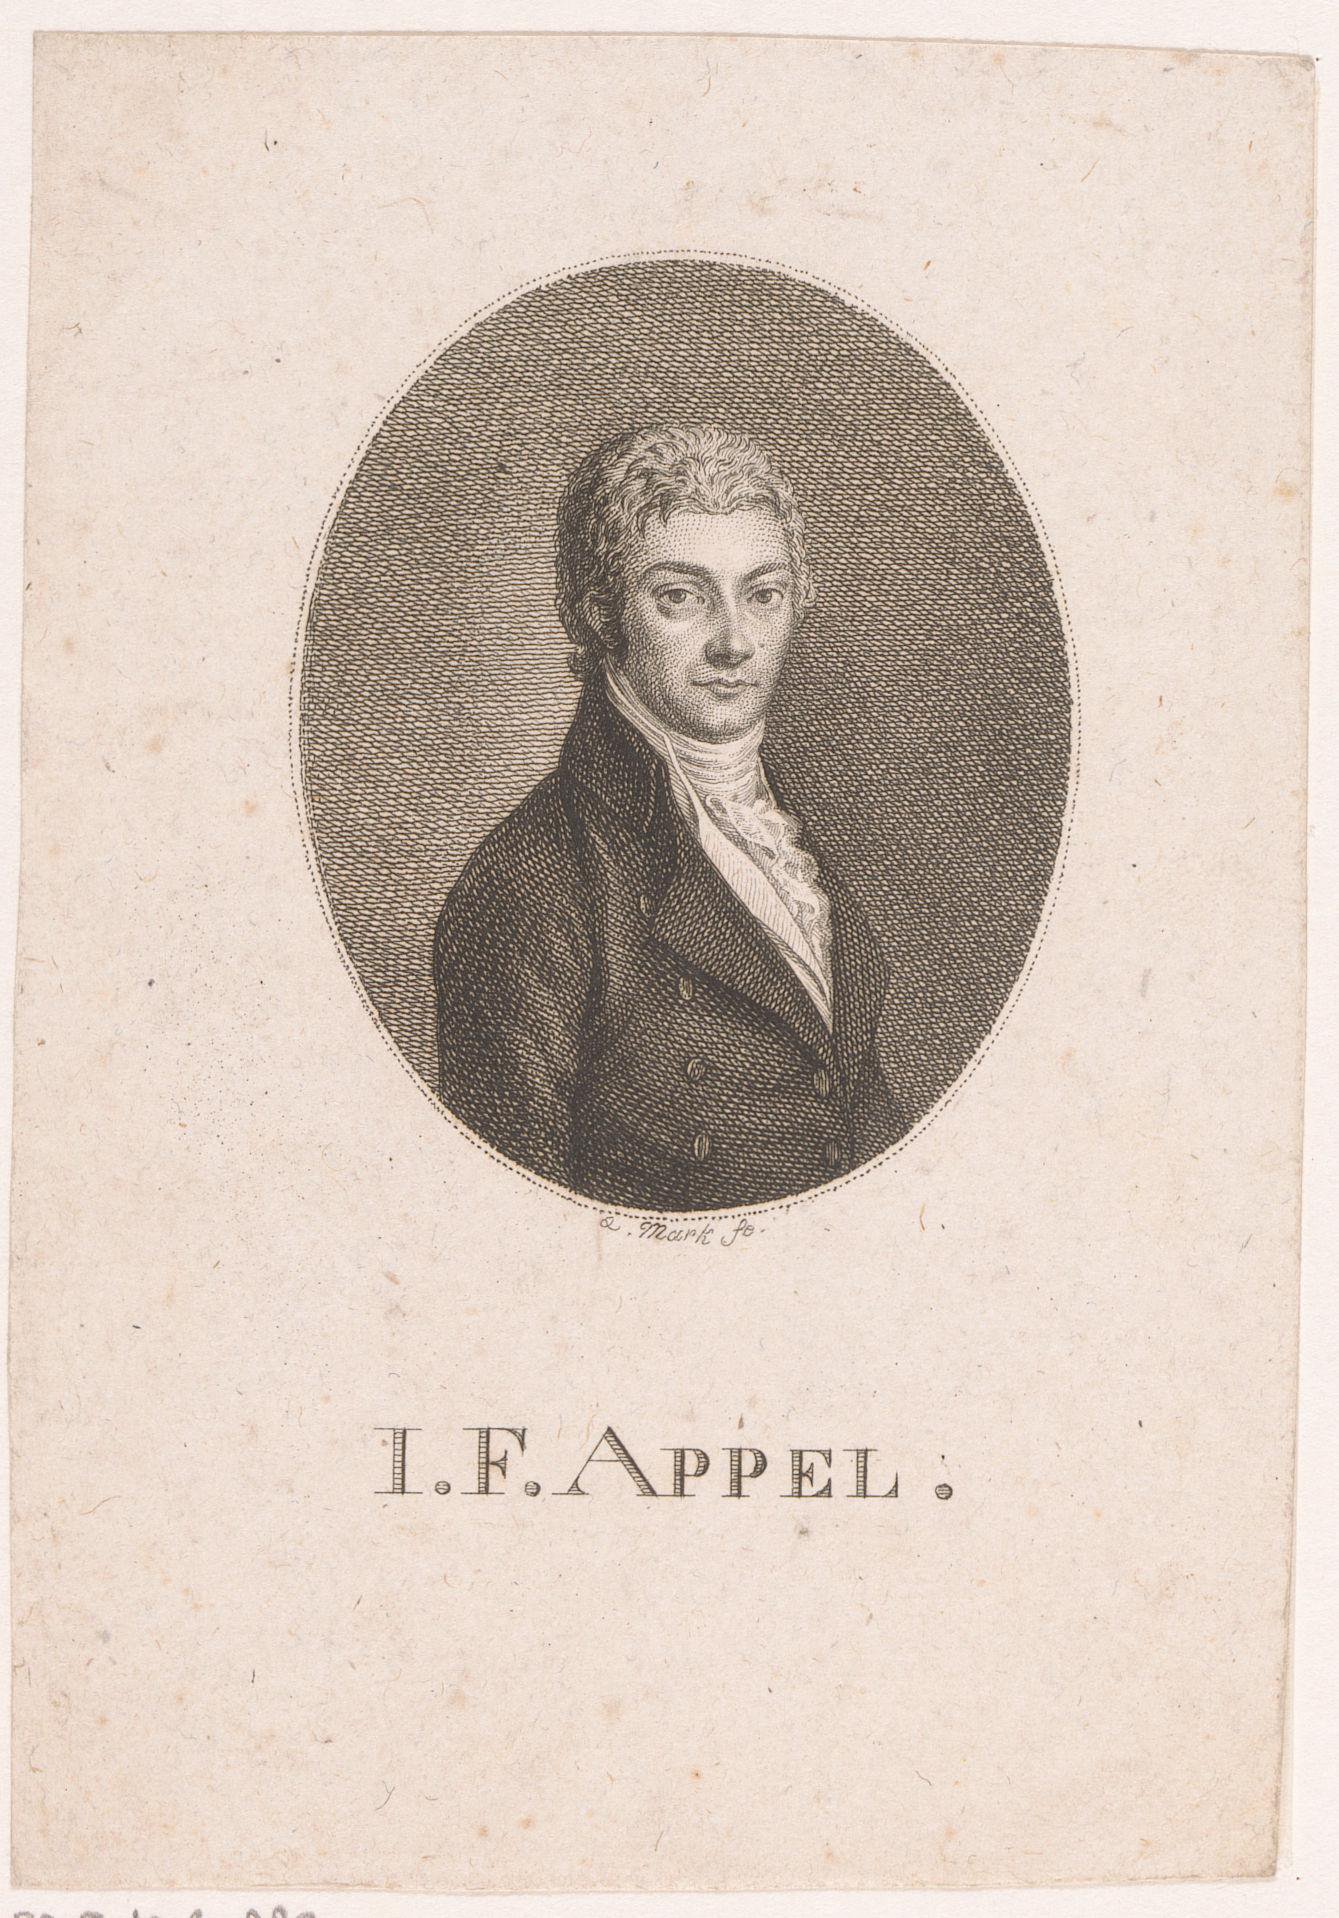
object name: print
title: Portret van Joseph Franz Appel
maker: quirin mark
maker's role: print maker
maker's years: 1753-1811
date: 1763-1811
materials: paper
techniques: engraving, etching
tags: vienna, historical persons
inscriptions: collector's mark: Lugt 2228